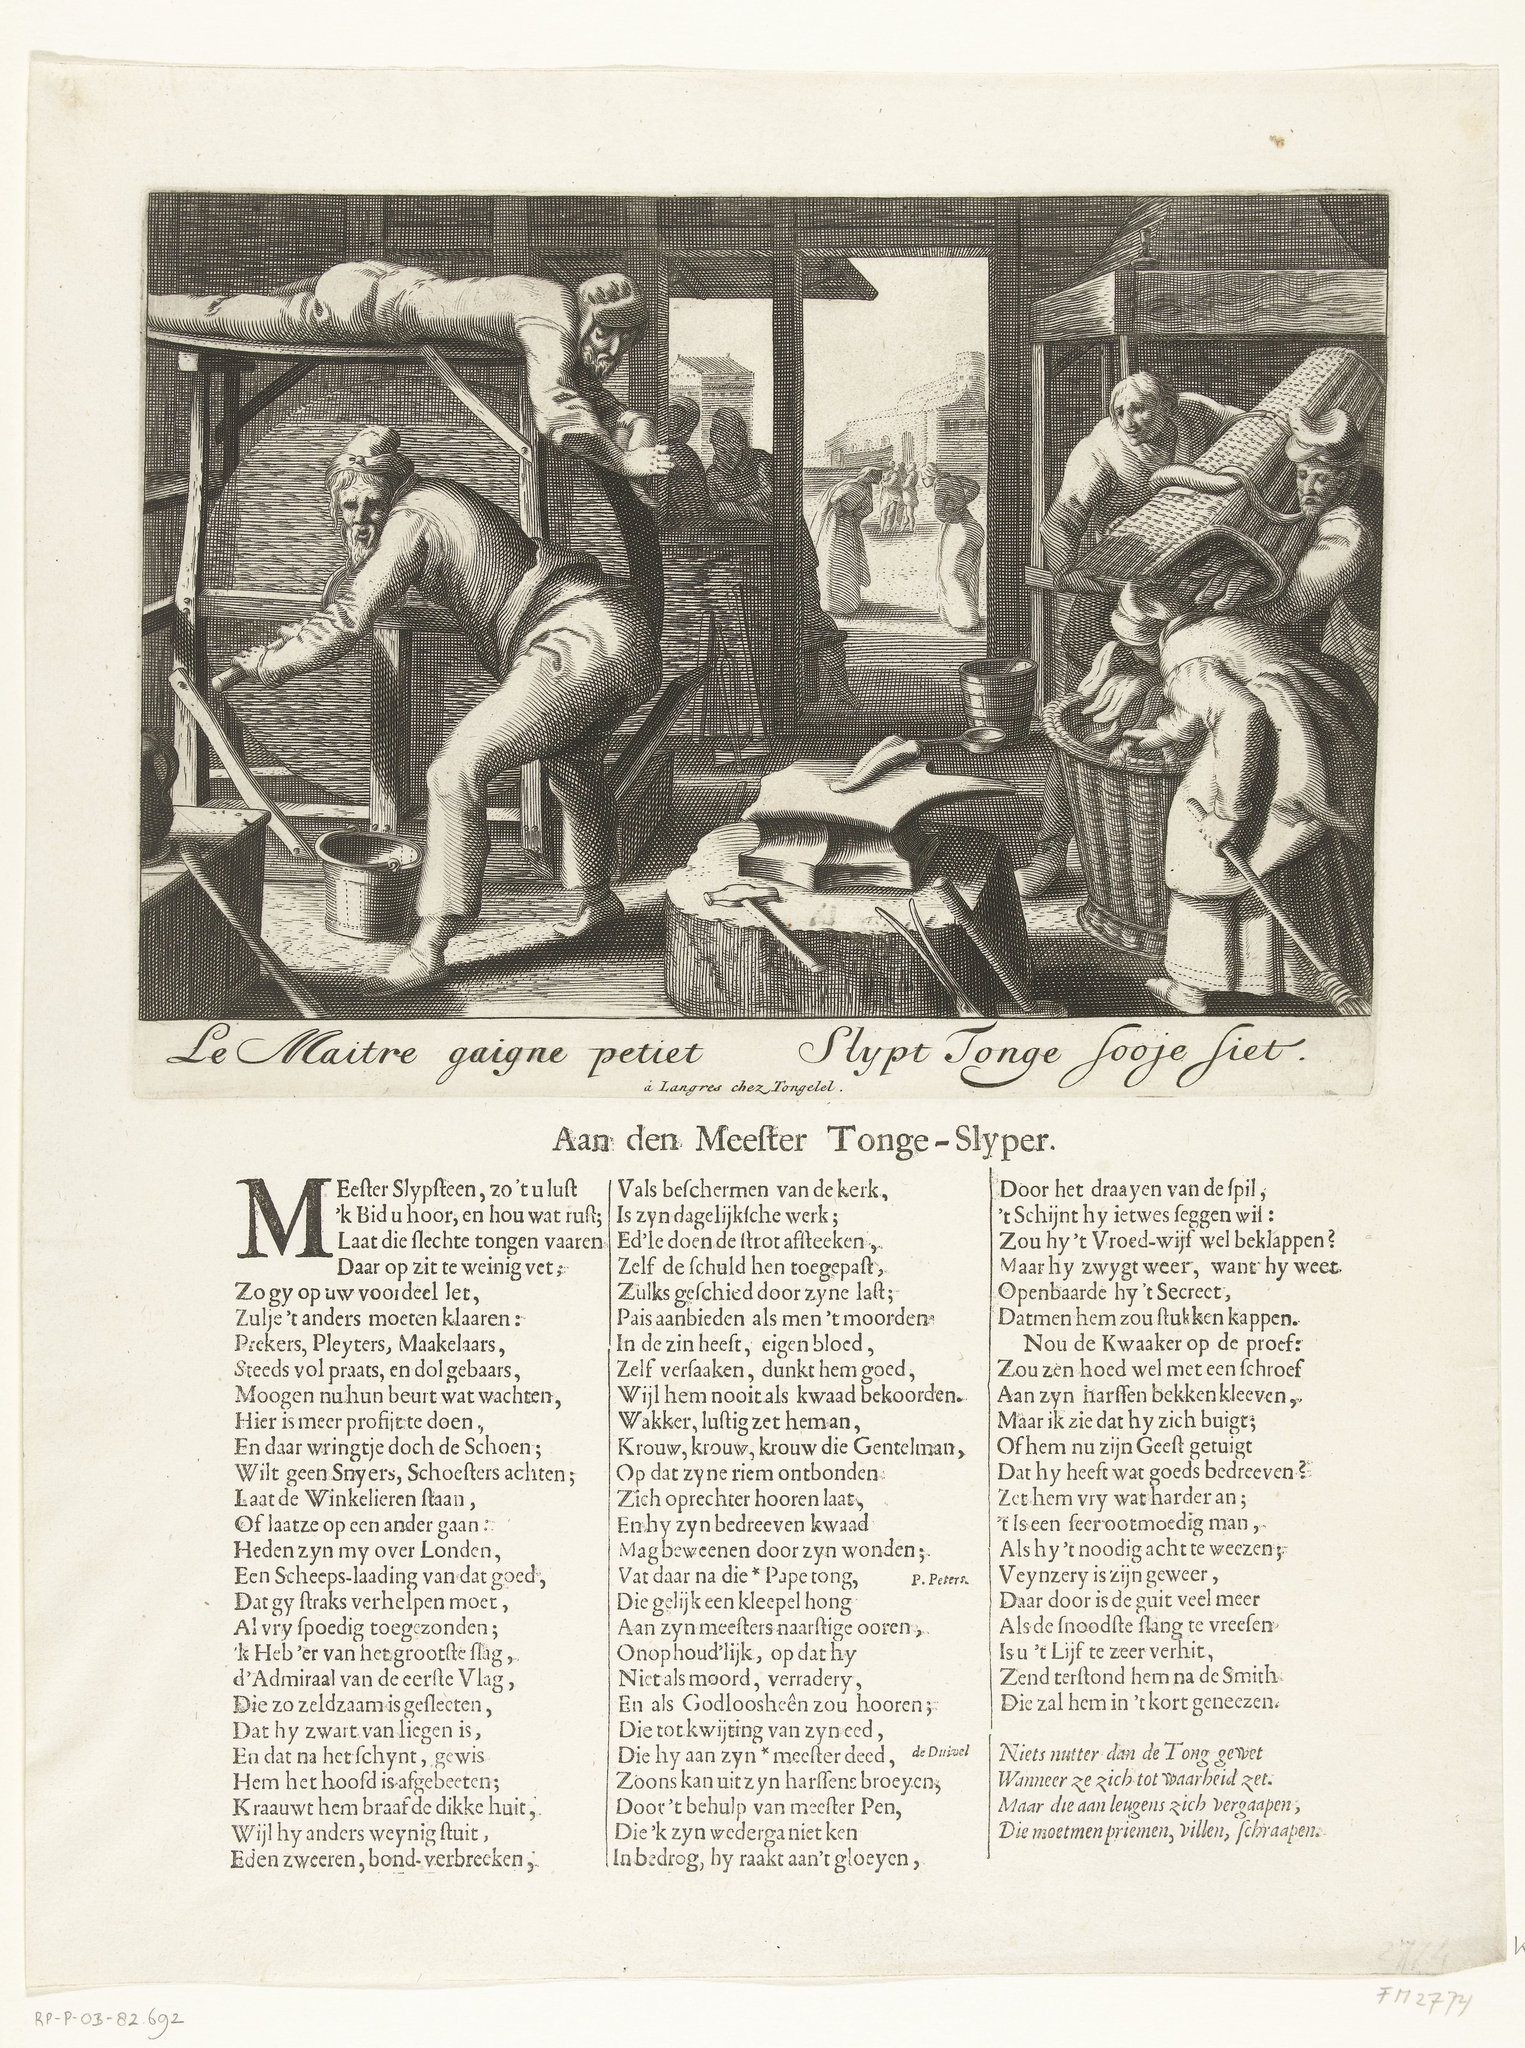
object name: cartoon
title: De tongenslijpers, 1689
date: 1592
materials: paper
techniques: engraving, letterpress printing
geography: northern netherlands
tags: jacobus ii (koning van engeland en schotland), sharpening, grinding (industrial processes), tongue, tools, aids, implements ~ crafts and industries: grindstone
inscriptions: collector's mark: Lugt 240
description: De tongenslijpers, 1689. Spotprent op koning Jacobus II en de katholieken in Engeland. In een werkplaats worden tongen die dik en zwart zijn van het liegen en kwaadspreken schoongeslepen. Rechts wordt een mand met tongen, waaronder de tongen van Jacobus II en pater Peters, die net uit Londen is gearriveerd omgekieperd. Op het blad onder de plaat is een tekst in 2 kolommen gedrukt.